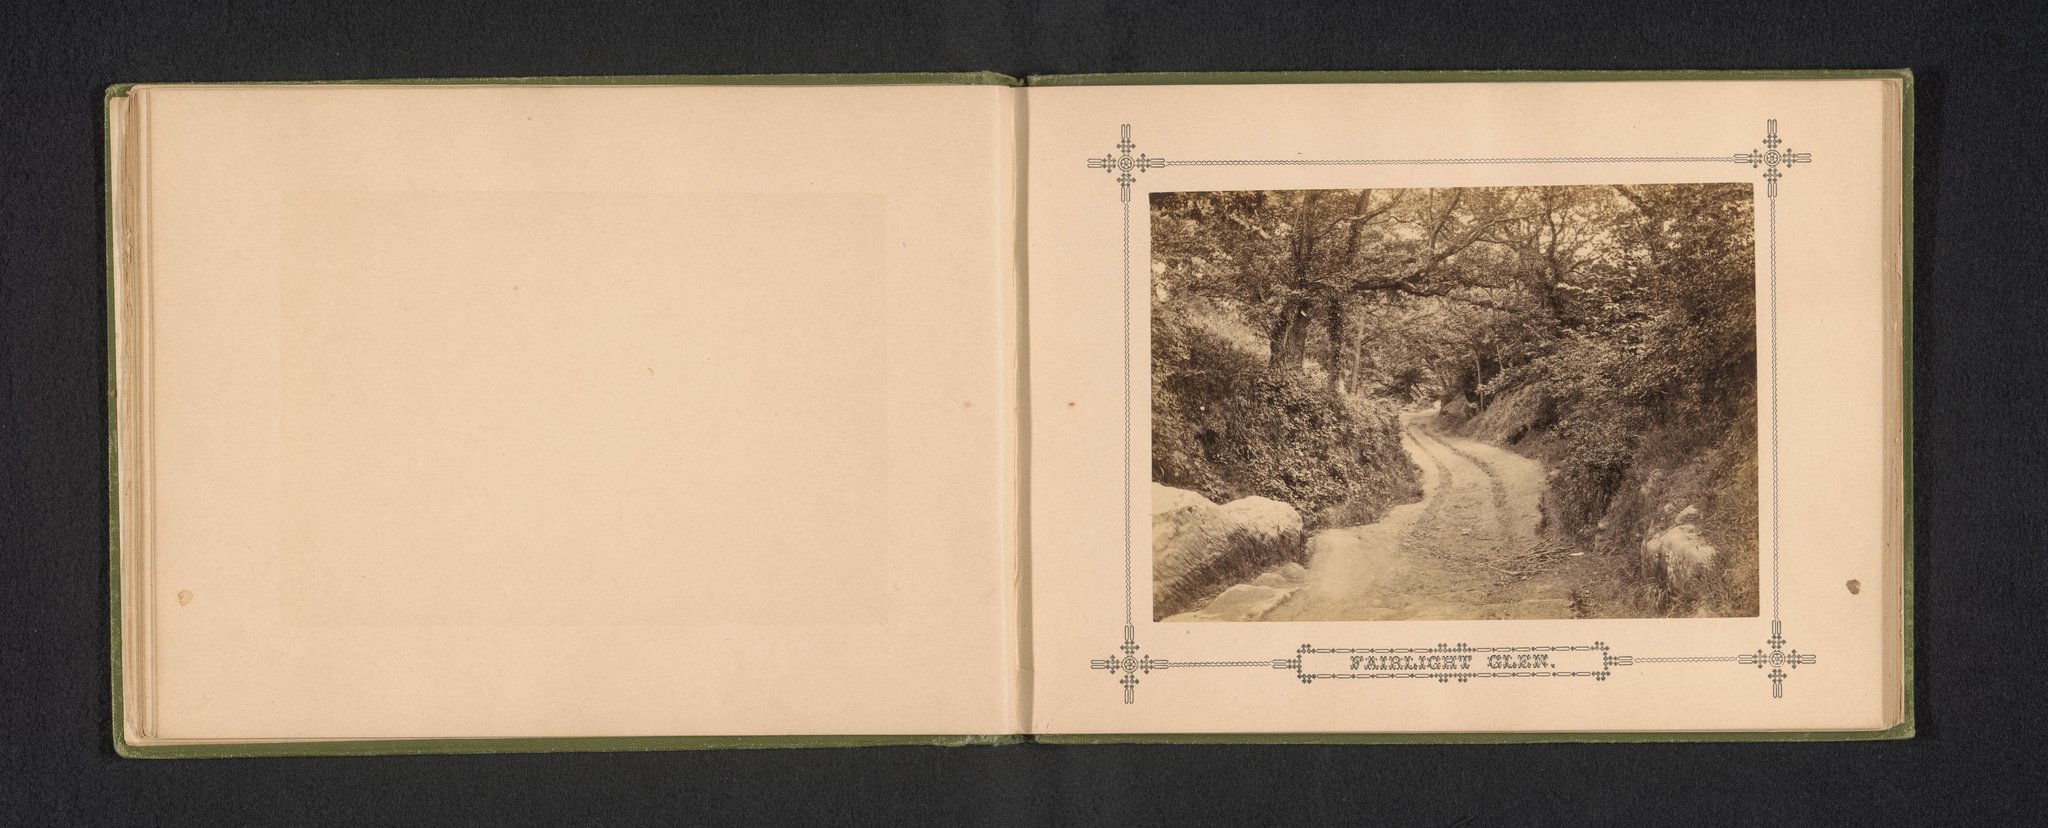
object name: page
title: Doorkijk in Fairlight Glen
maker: wm. e. thorpe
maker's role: fotograaf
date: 1870-1875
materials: photographic support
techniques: albumen print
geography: hastings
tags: forest, wood, forest path or lane